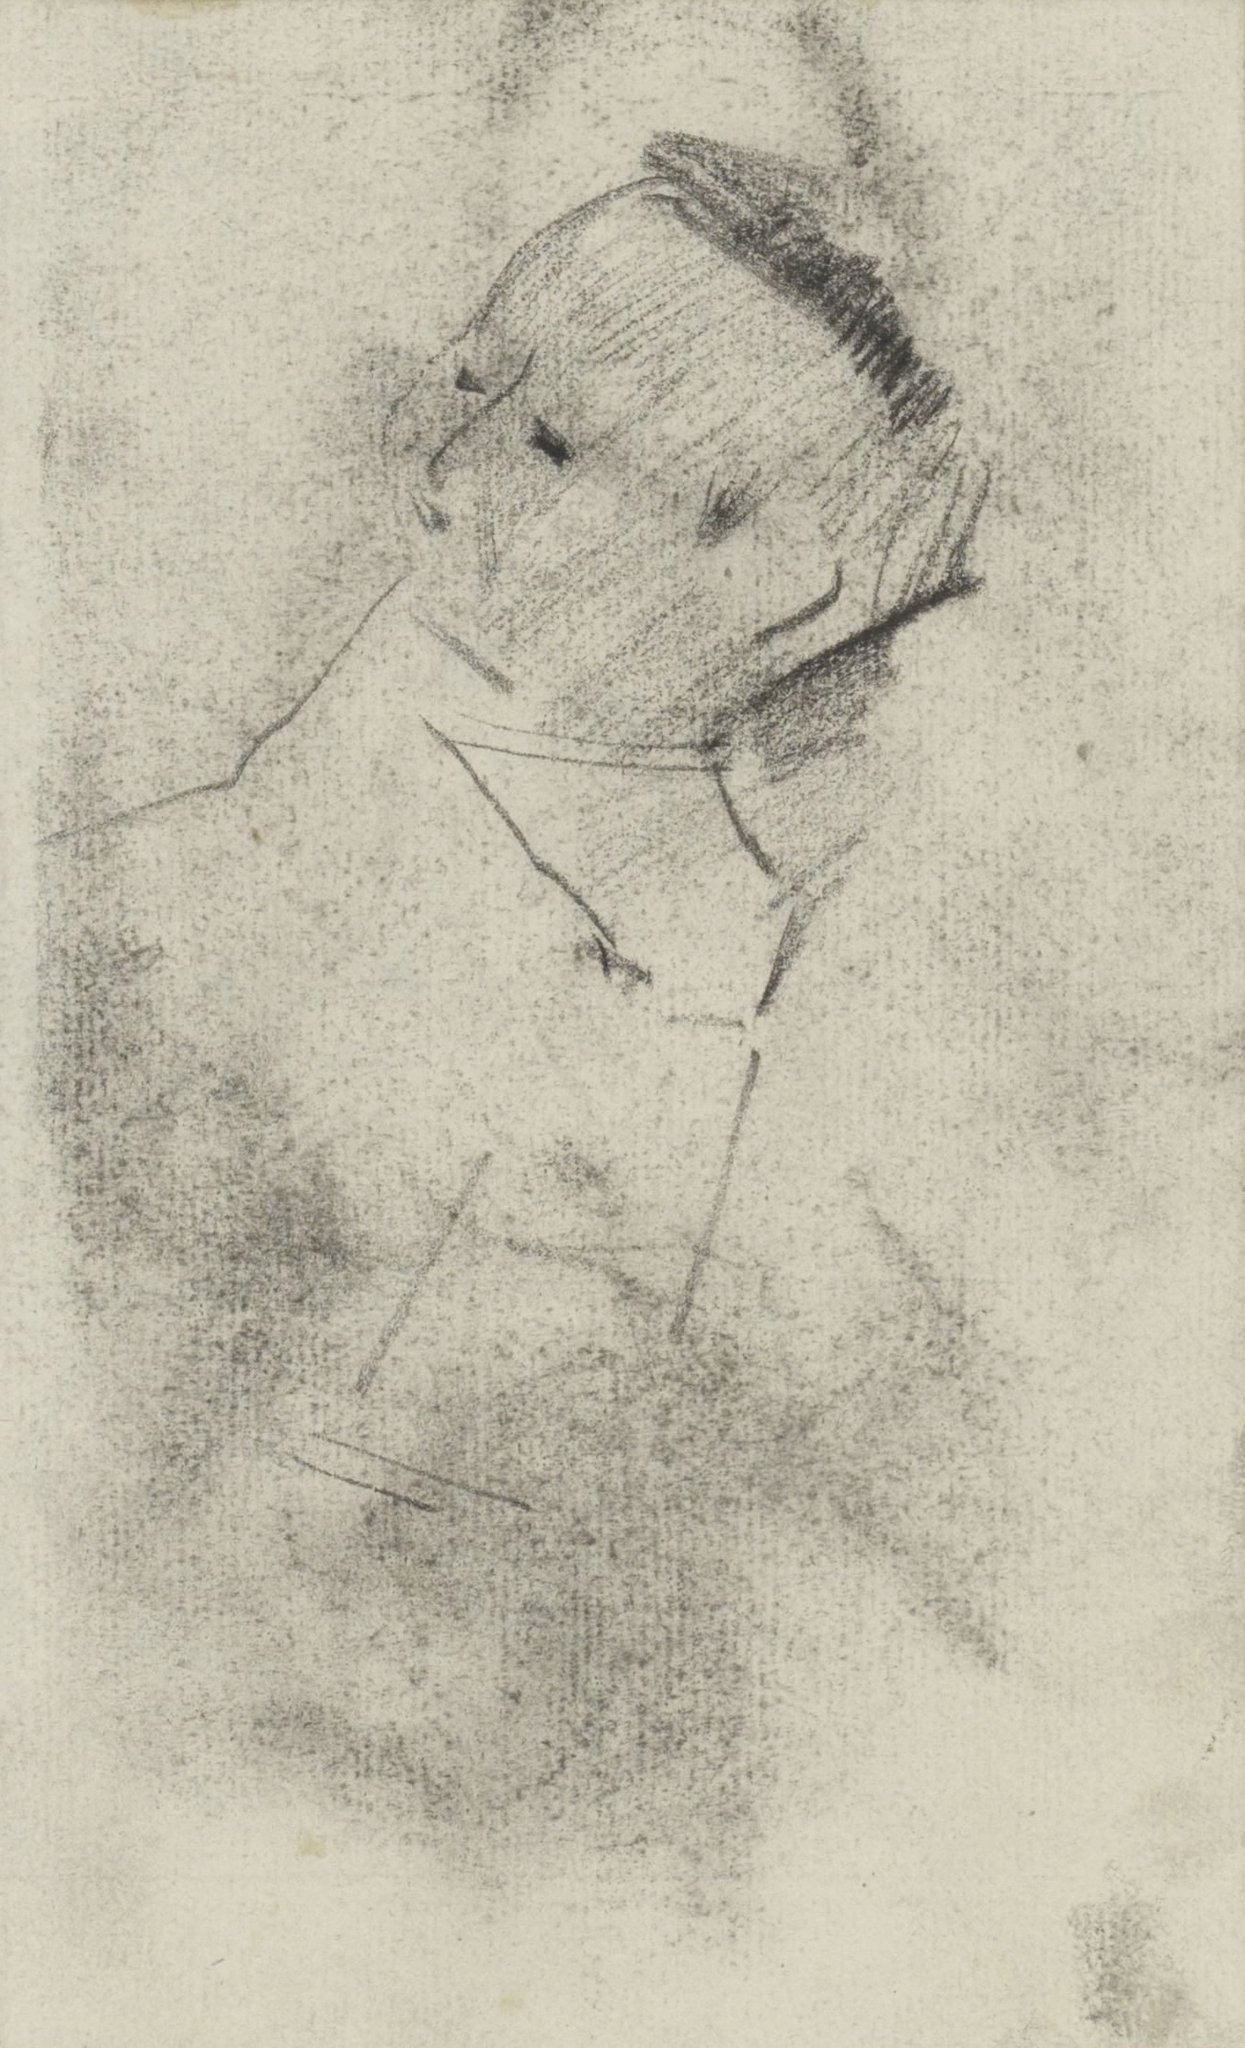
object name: drawing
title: Buste van een kind, mogelijk een jongen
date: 1887-1891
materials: chalk, paper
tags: male infant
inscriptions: workshop stamp: Lugt 291d, collector's mark: Lugt 2228